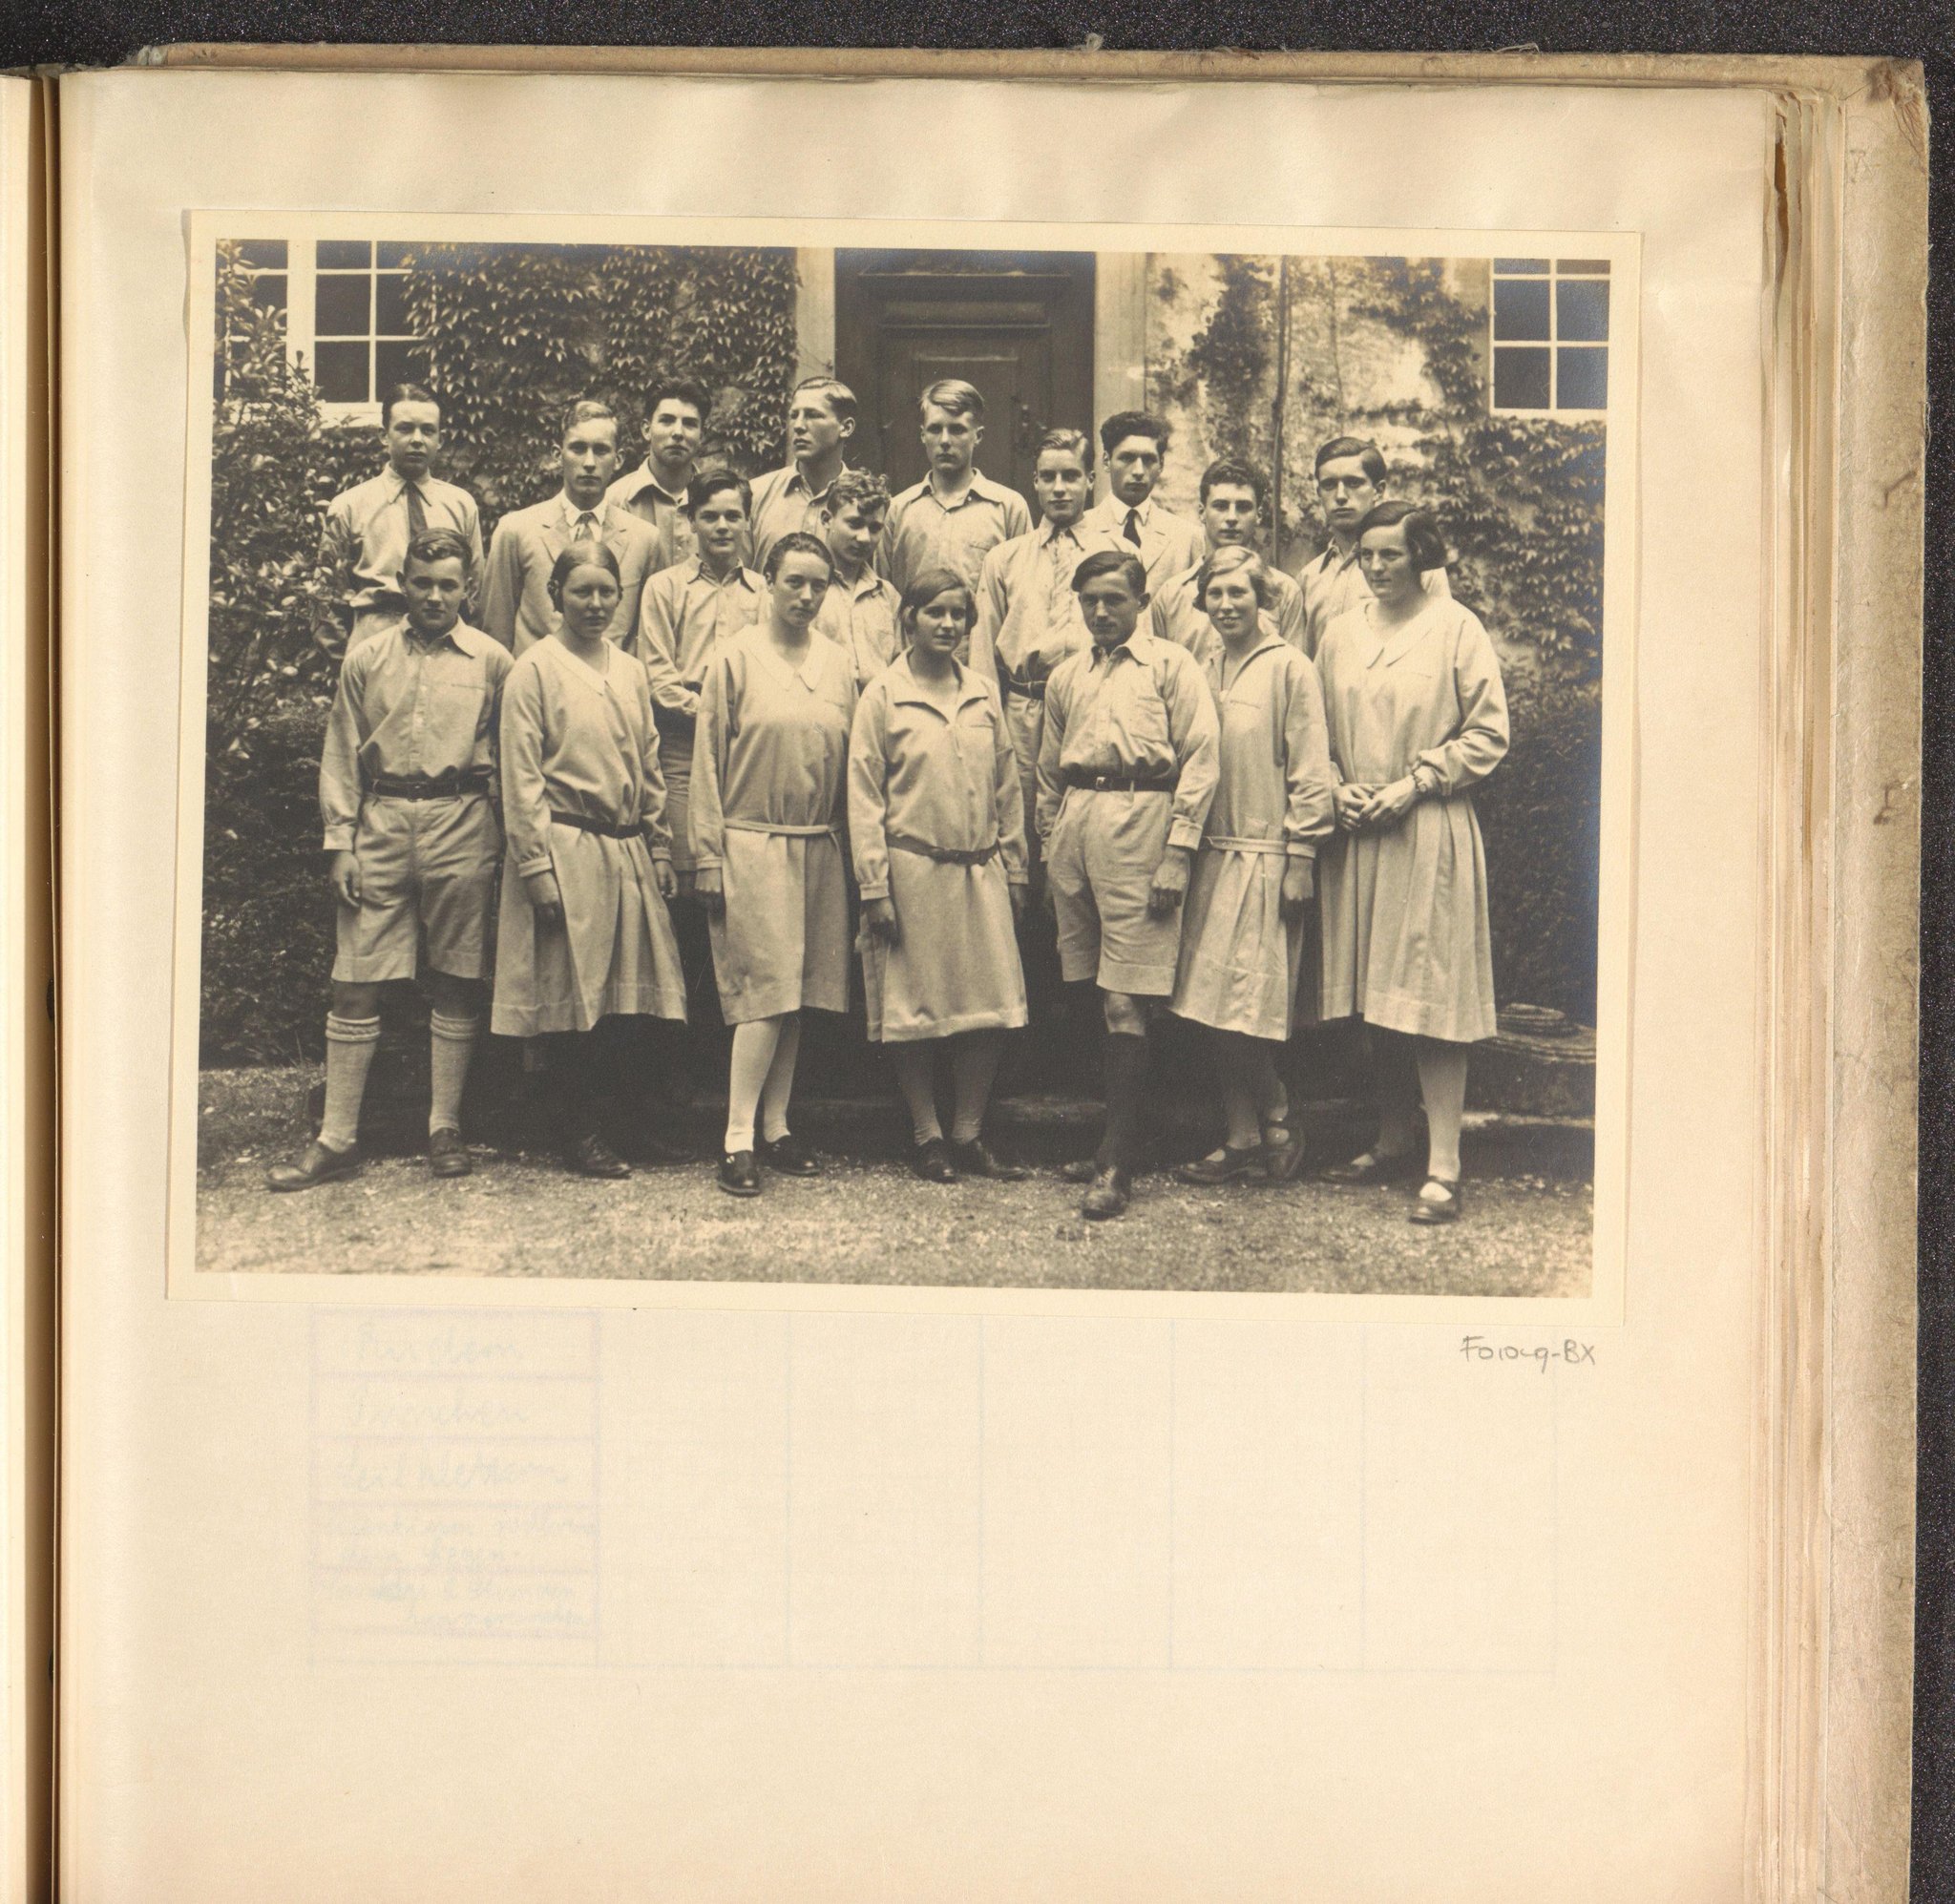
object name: photograph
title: Groepsportret van verkozen leerlingen van Schule Schloss Salem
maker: Anonymous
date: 1929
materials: photographic support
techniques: gelatin silver print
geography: salem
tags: student - bb - female student, education, student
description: Onderdeel van Fotoalbum van Schule Schloss Salem.